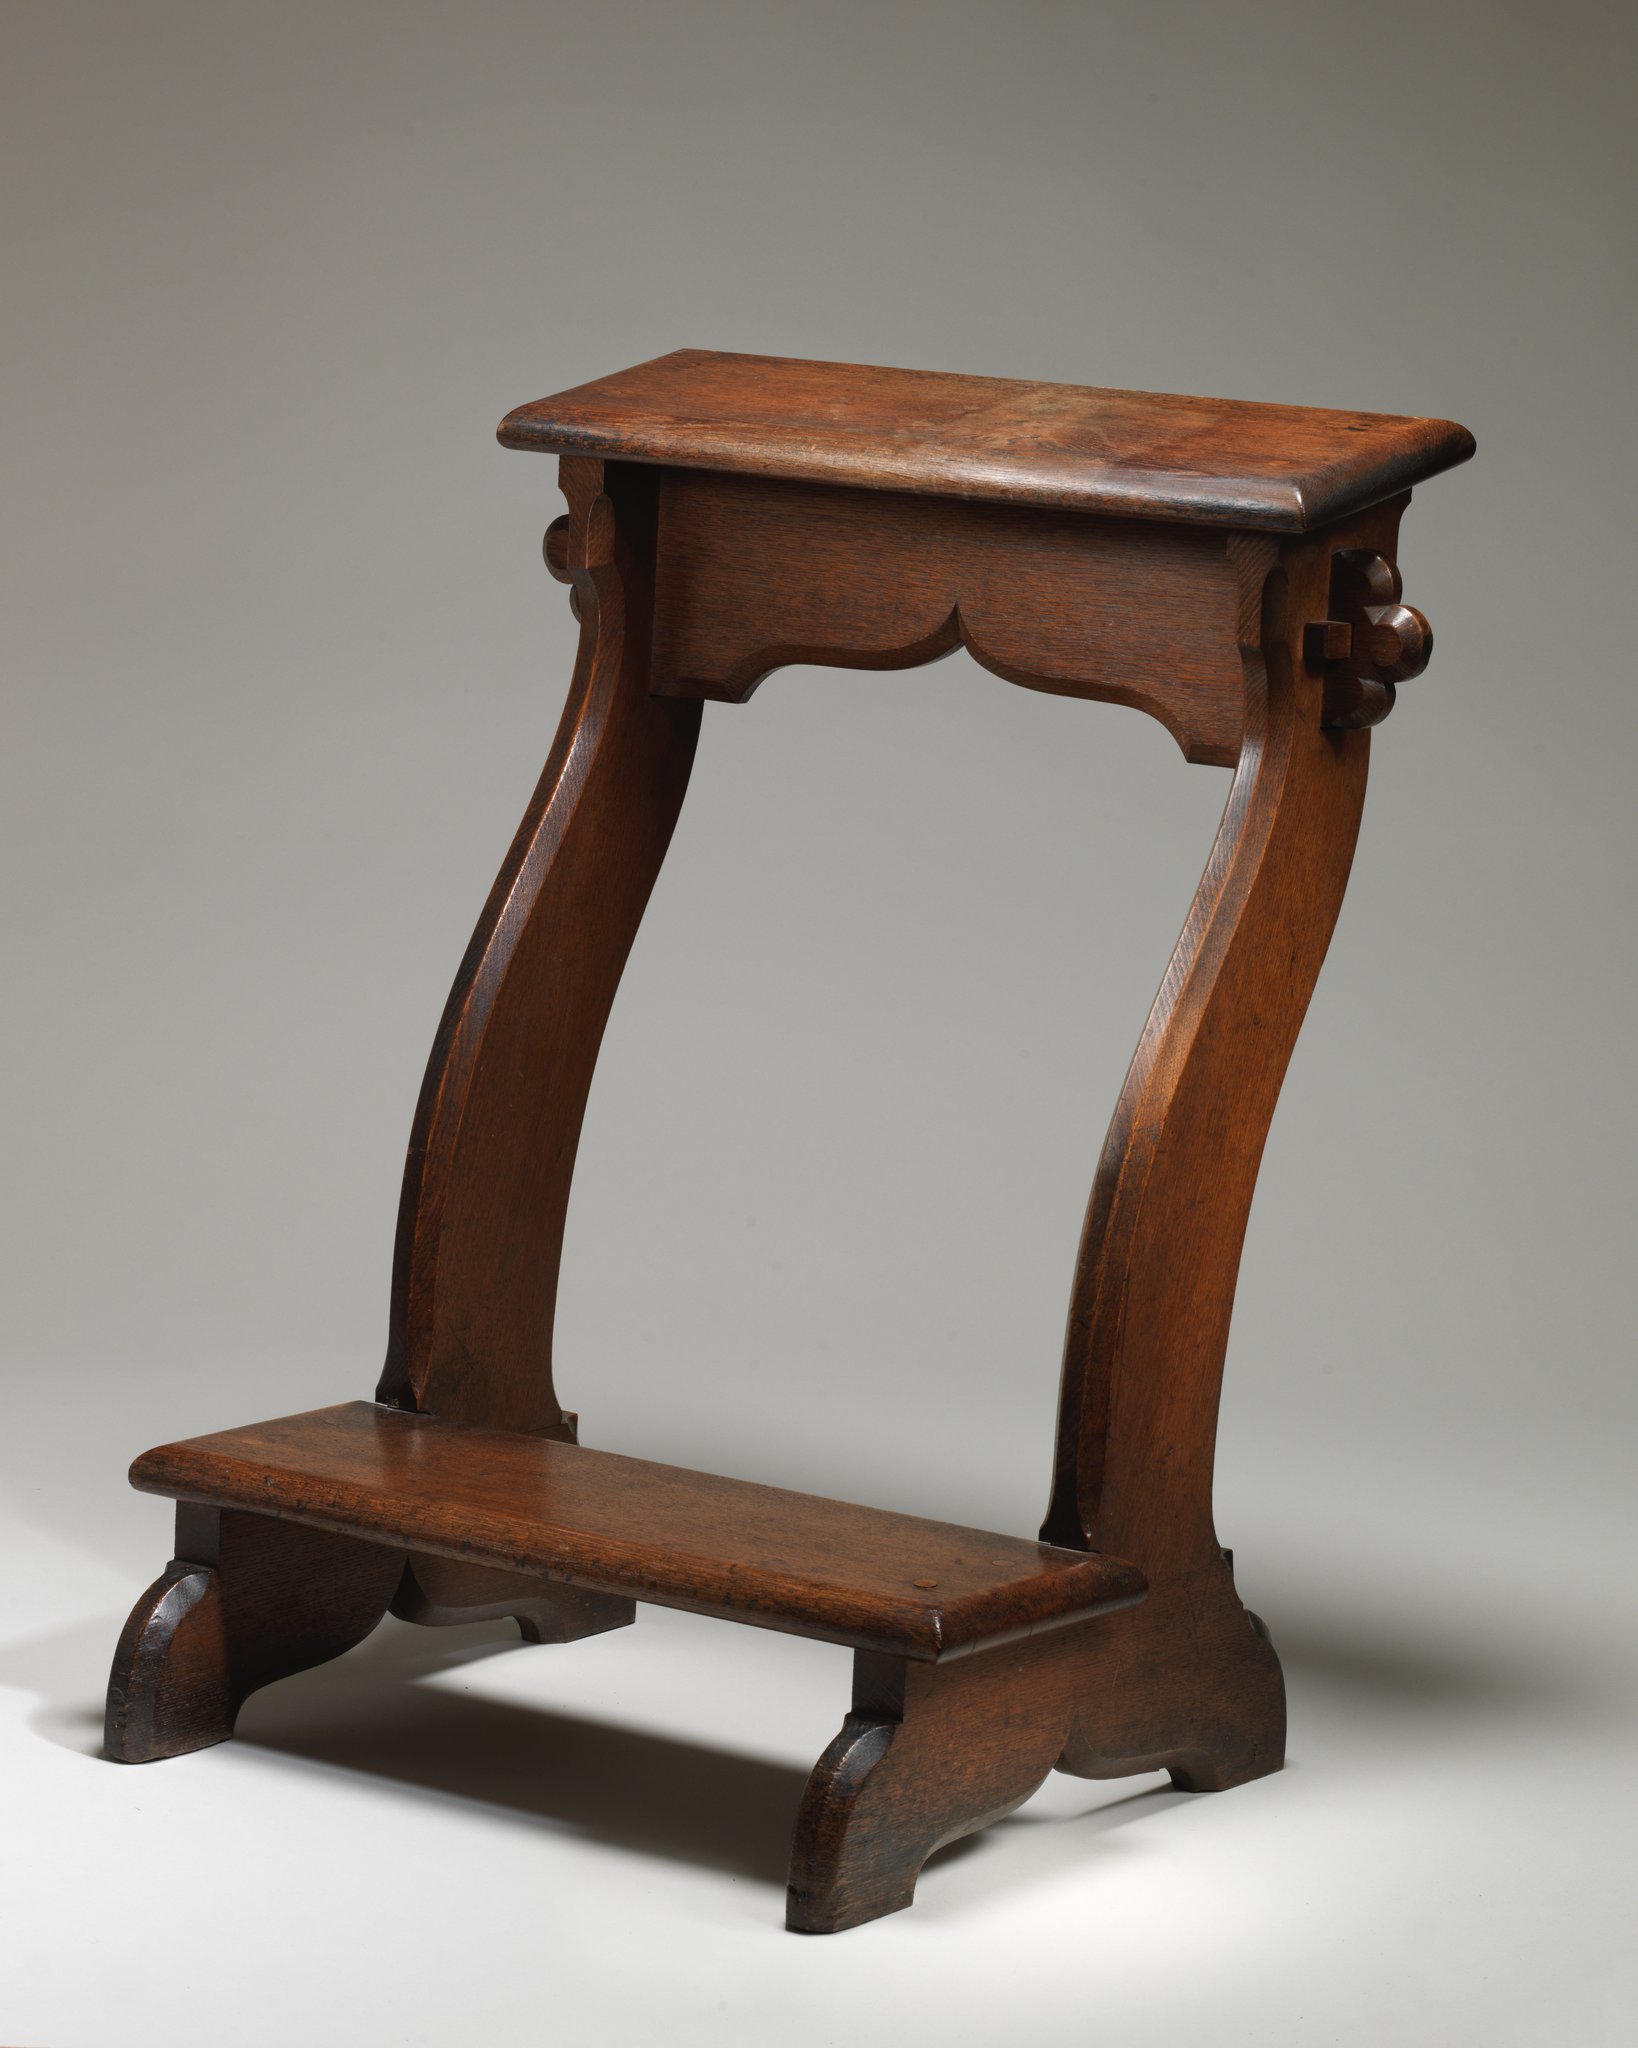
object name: prie dieu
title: Prayer desk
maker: augustus welby northmore pugin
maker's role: designer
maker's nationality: british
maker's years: 1812-1852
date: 1844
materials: wood